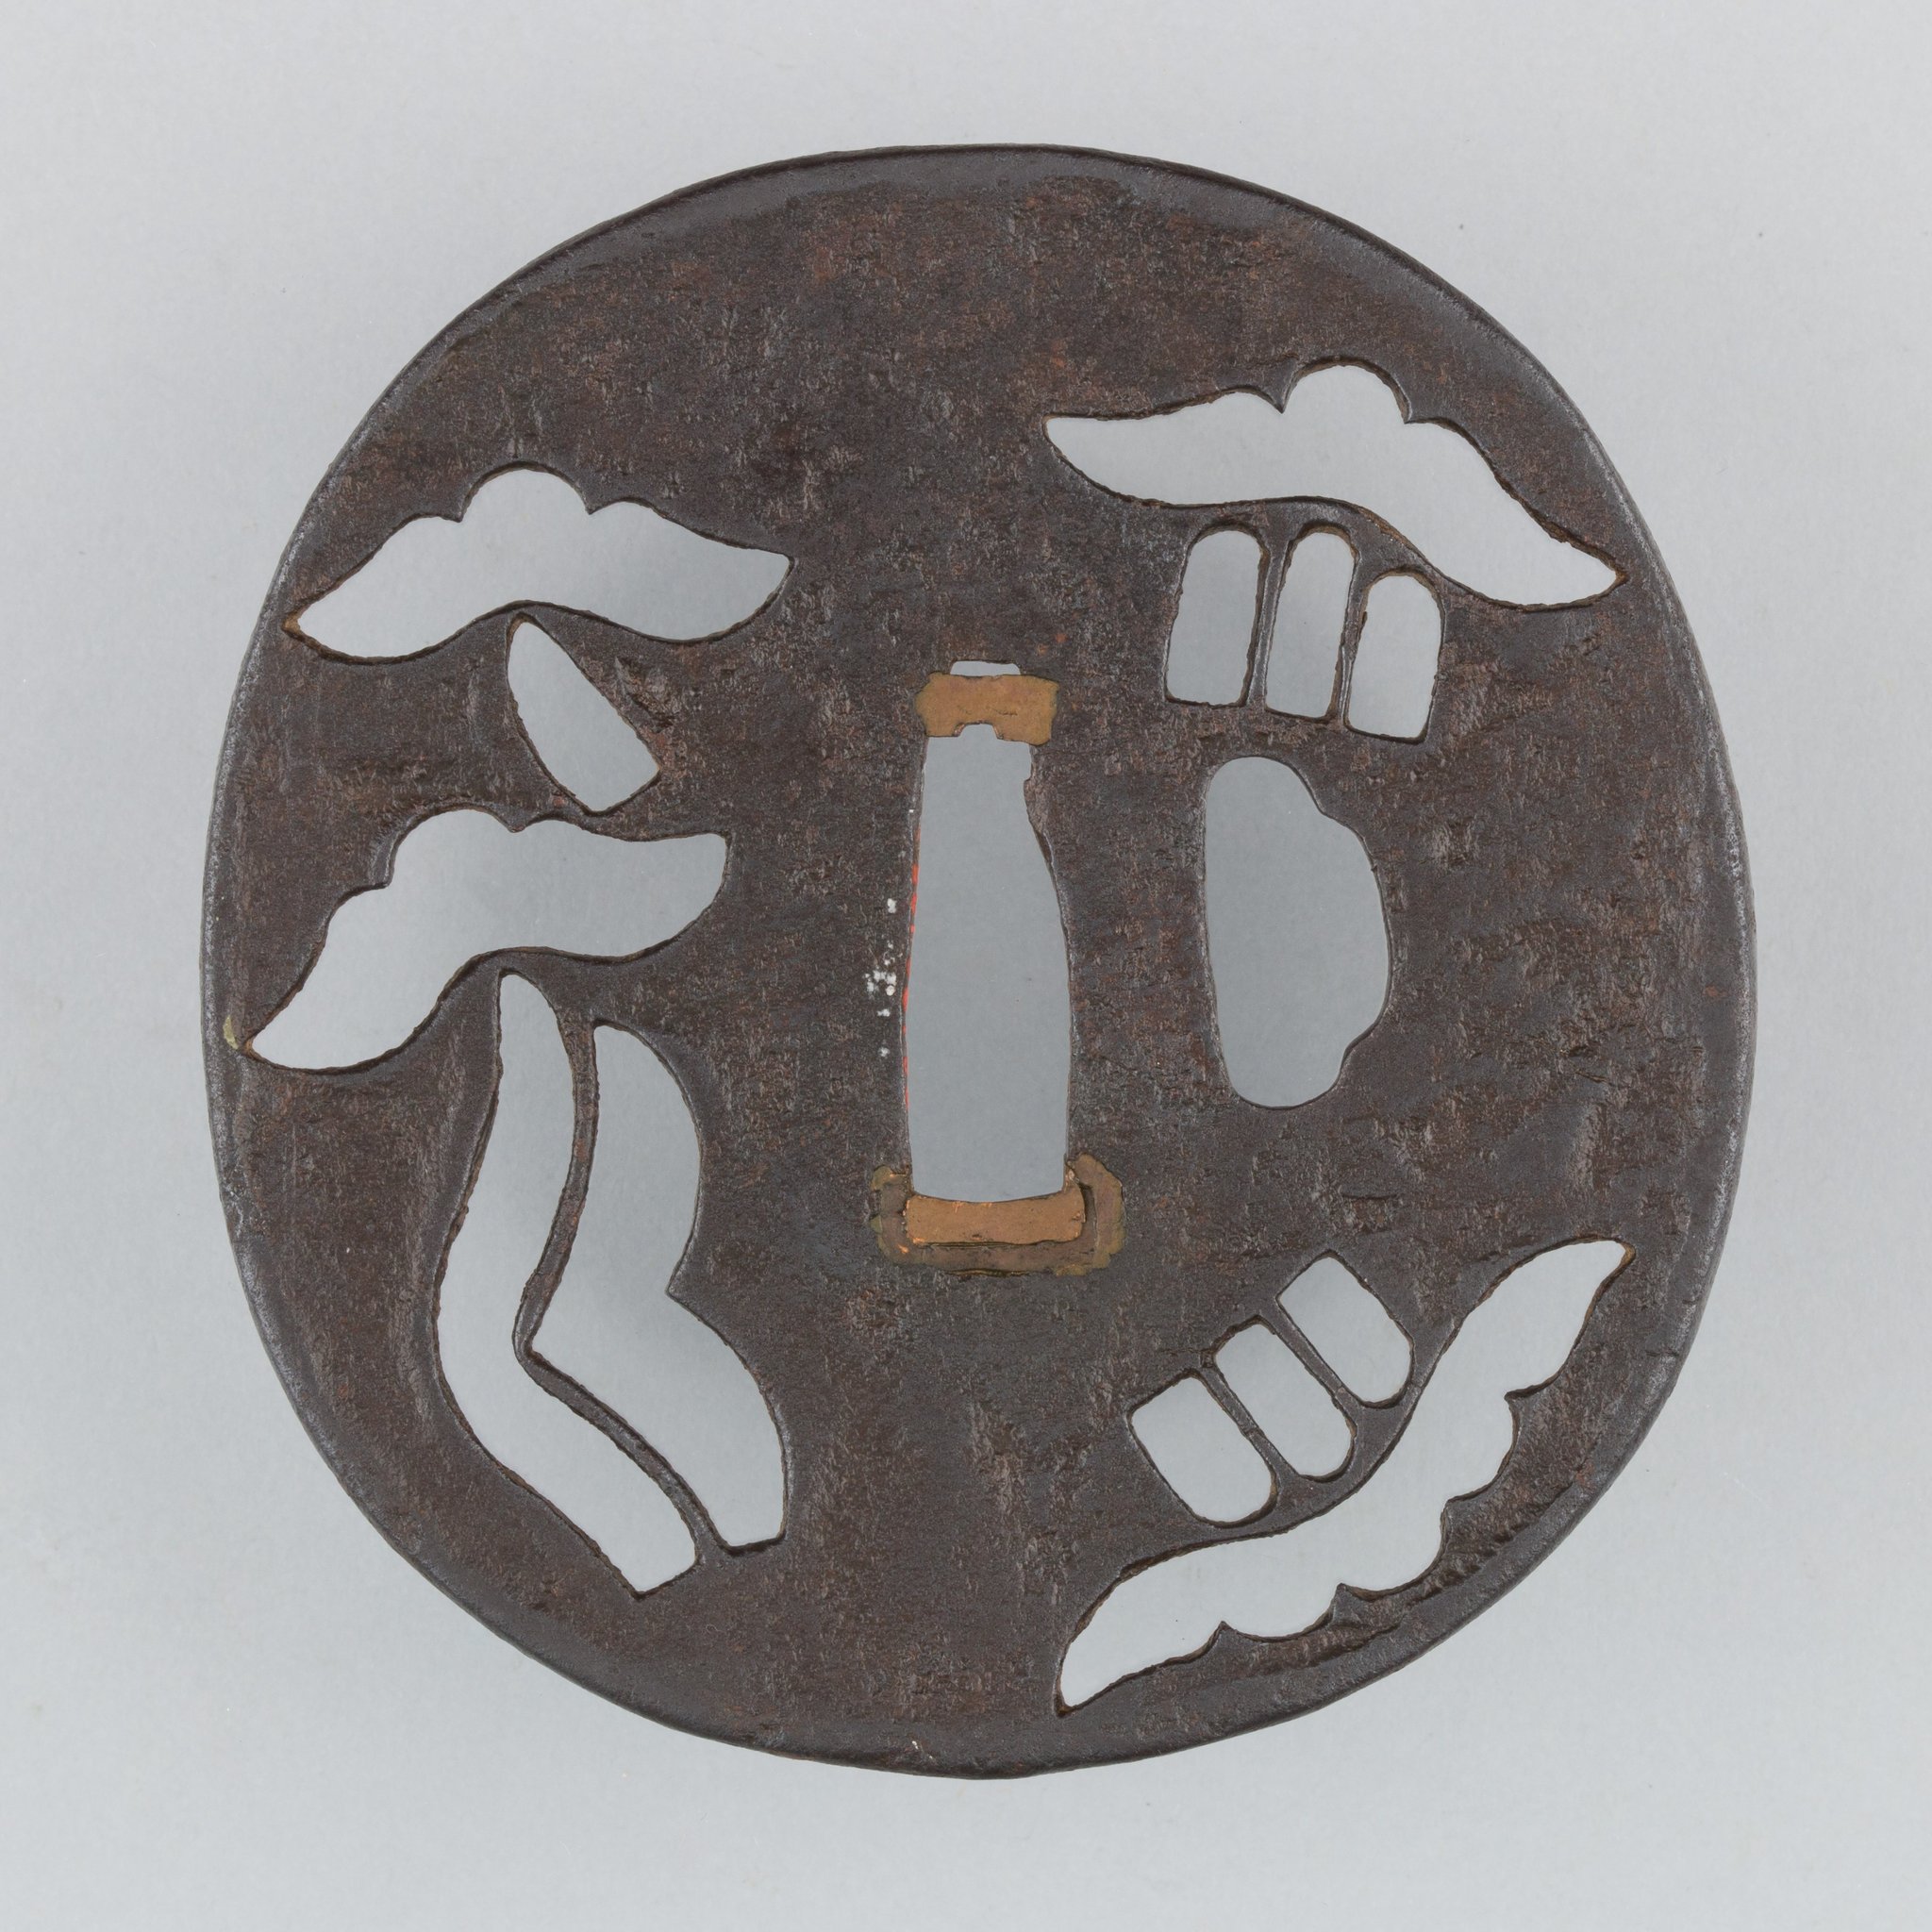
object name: sword guard tsuba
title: Sword Guard (Tsuba)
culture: japanese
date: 1567-1633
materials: copper, iron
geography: japan